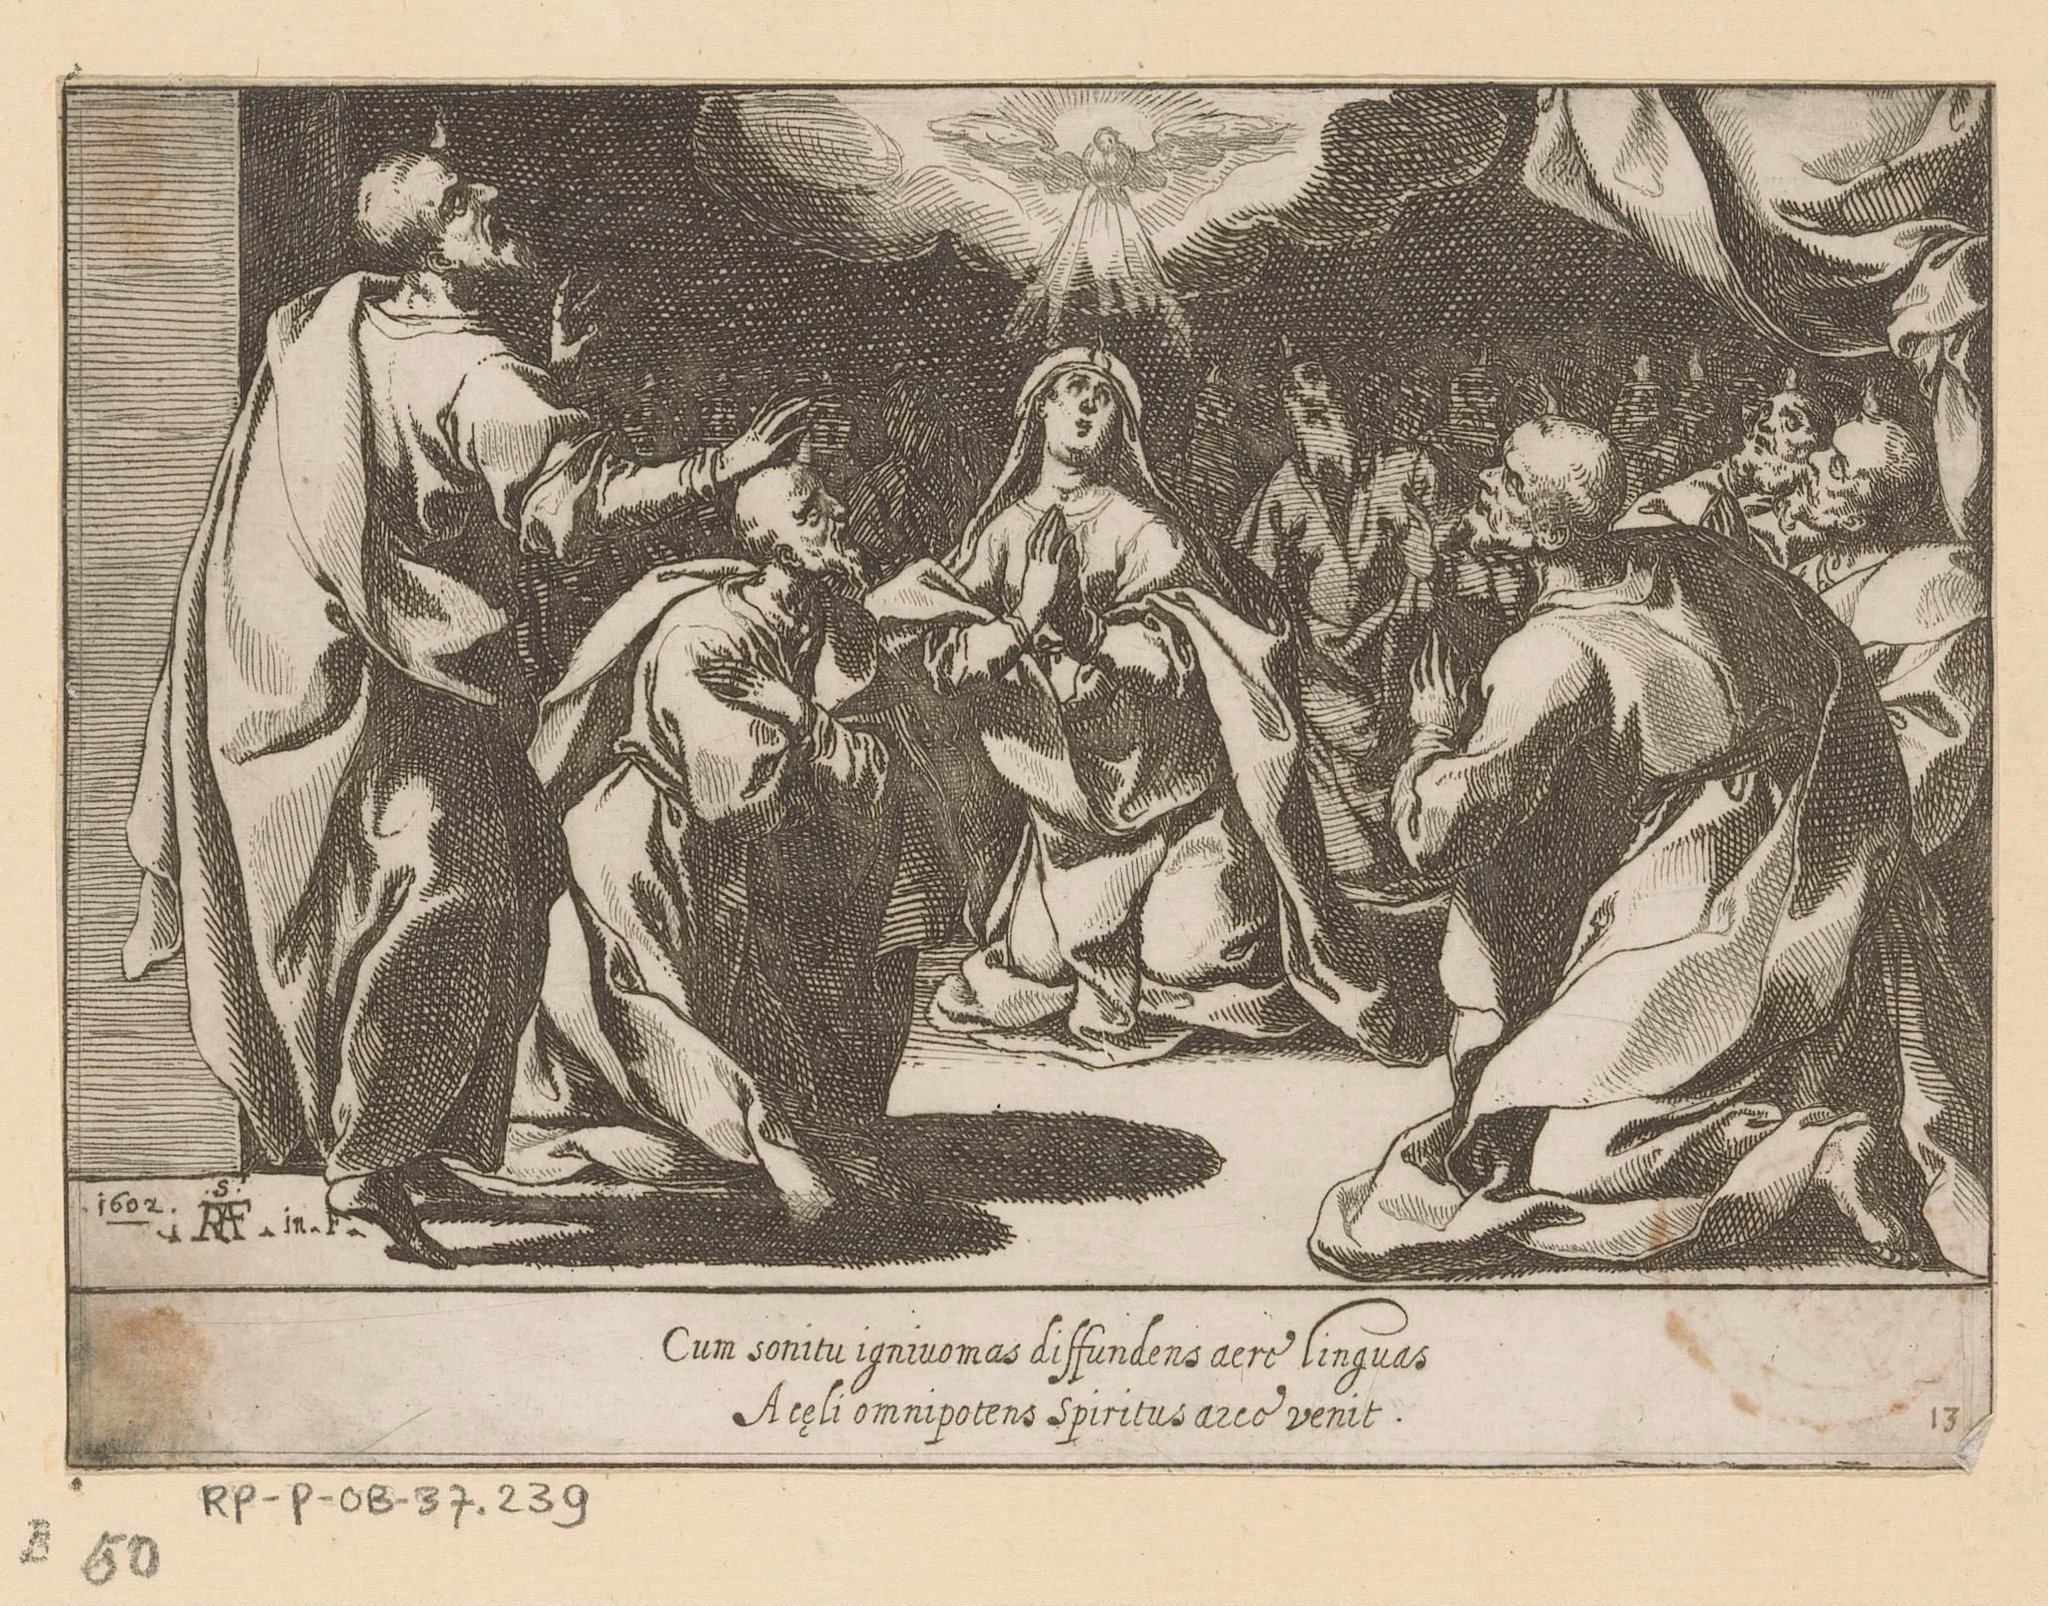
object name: print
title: Pinksteren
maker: raffaello schiaminossi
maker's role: painter, print maker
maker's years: 1572-1622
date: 1602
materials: paper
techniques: etching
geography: rome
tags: pentecost: the holy ghost descends upon (mary and) the apostles, sometimes paul and/or representatives of the nations present (acts 2:1-4)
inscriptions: collector's mark: Lugt 240, number: ‘13’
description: De prent maakt deel uit van de serie 'Quindecim Mysteria Rosarii Beatae Mariae Virginis'. De serie bestaat uit een titelprent en vijftien prenten met voorstellingen van de Mysteries van de Rozenkrans (episodes uit de levens van Christus en Maria). In een andere staat is de prent in de plaat genummerd linksonder: 13.